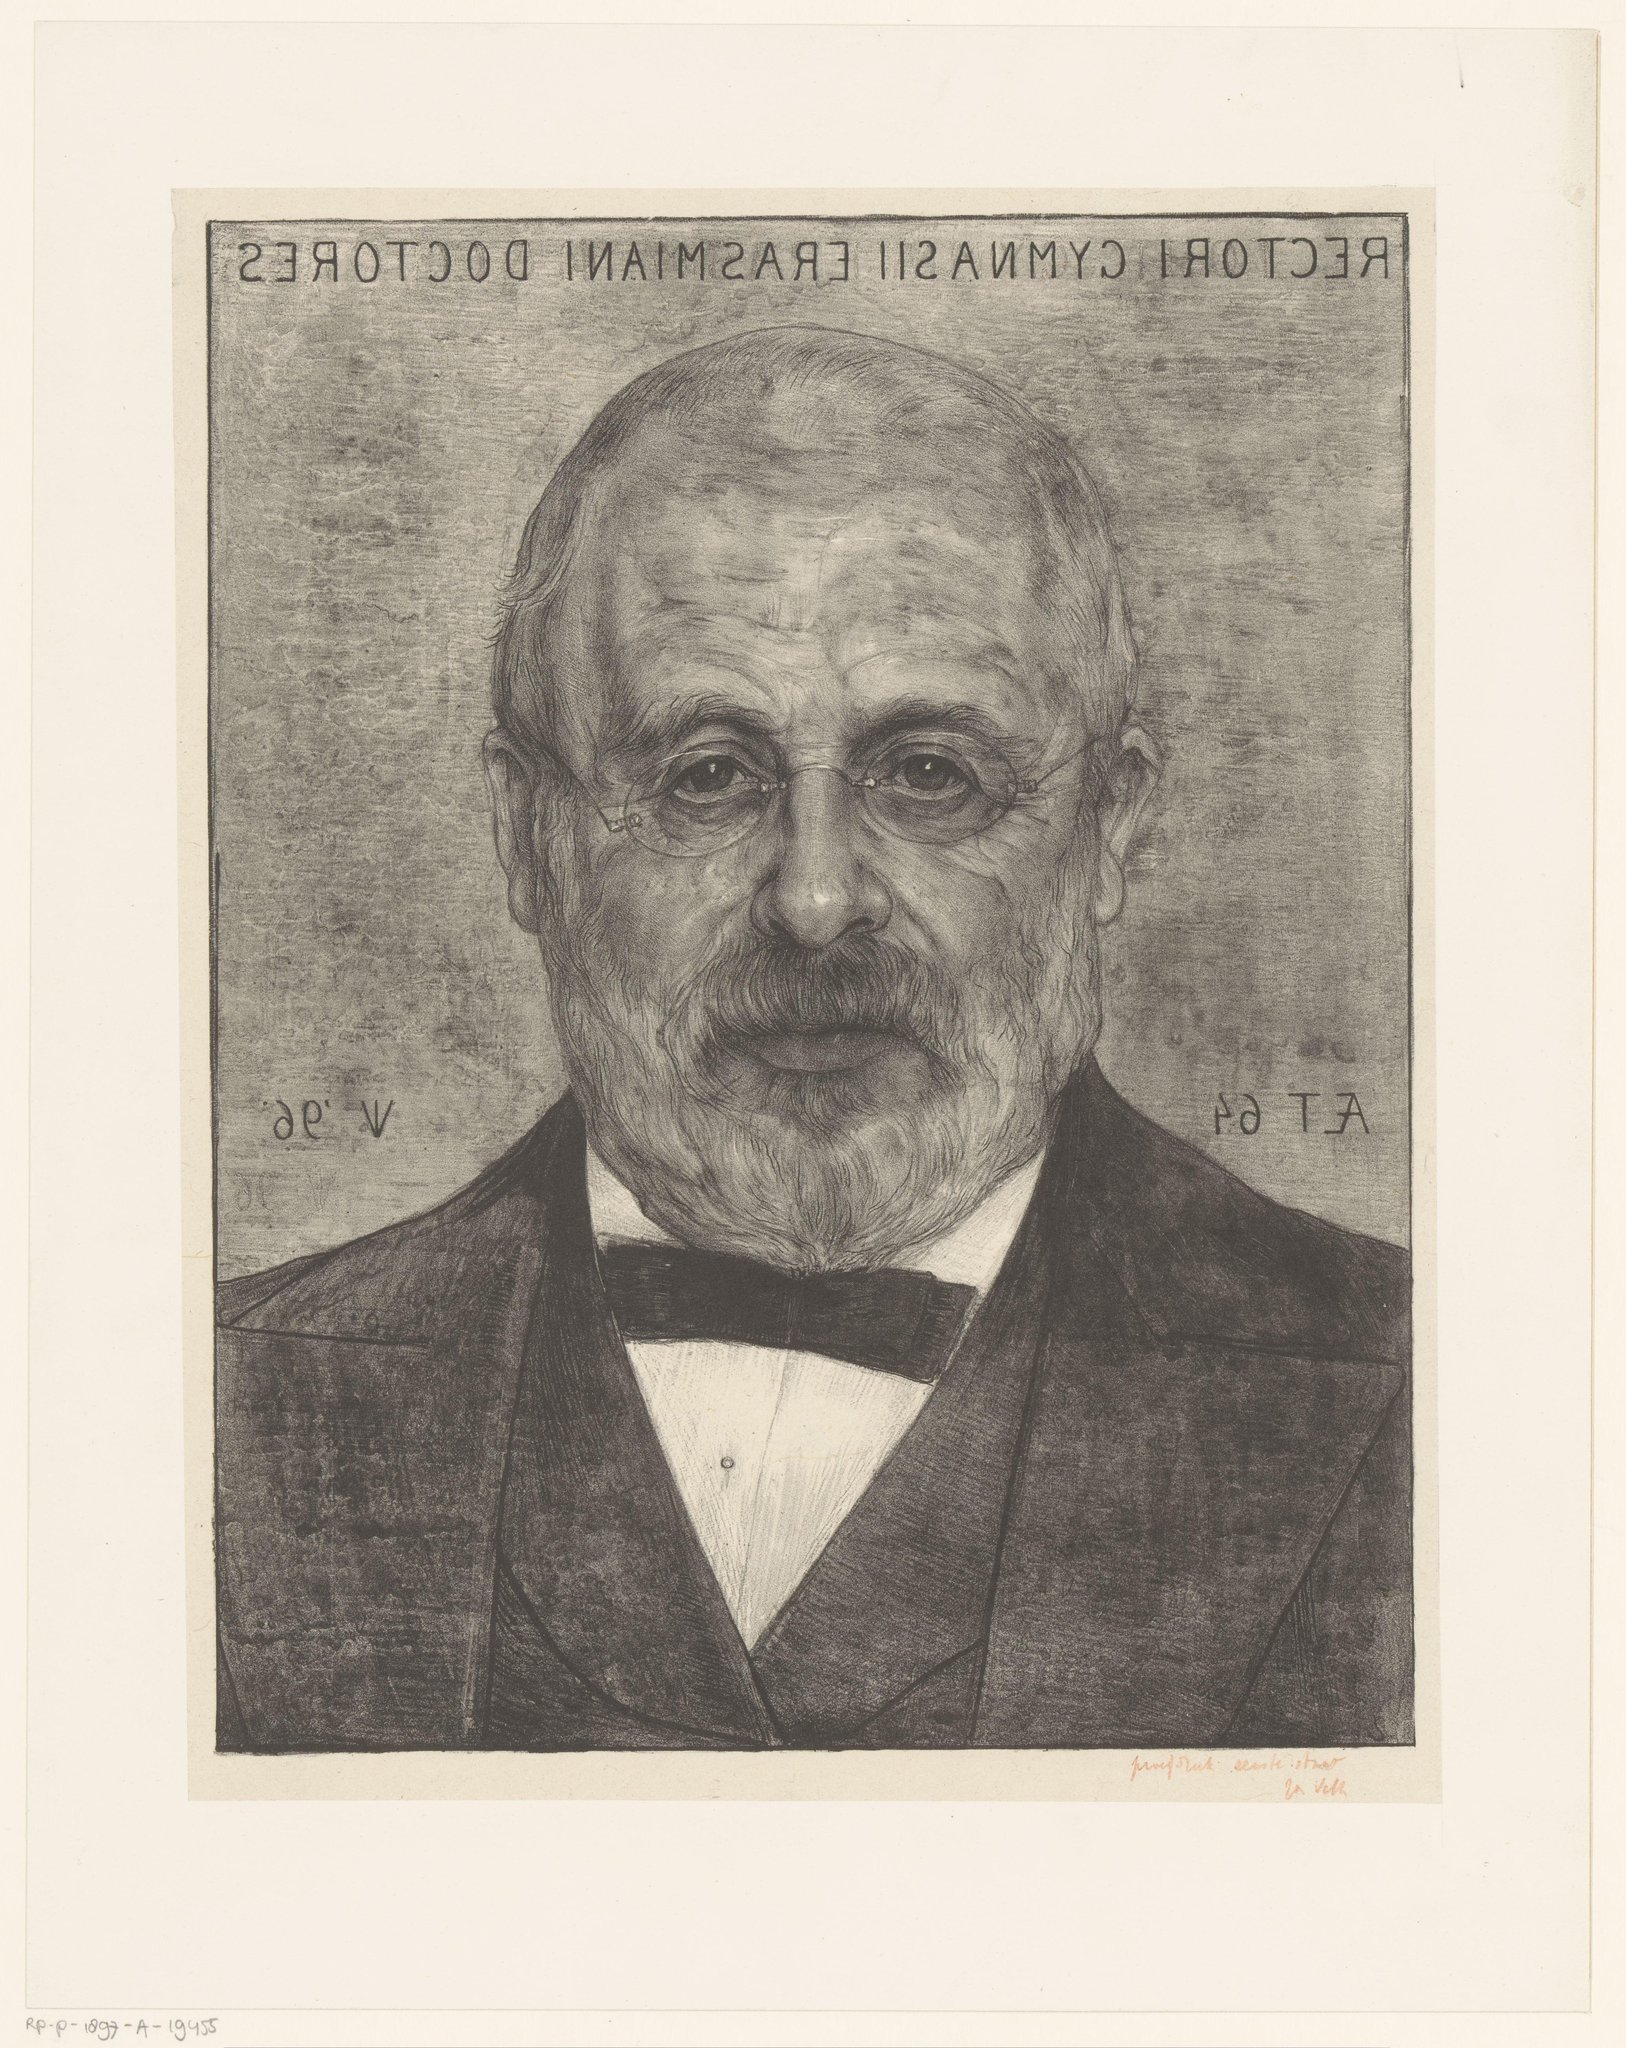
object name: print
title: Portret van Johannes Benedictus Kan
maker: jan veth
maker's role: designer, draughtsman, painter, print maker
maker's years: 1864-1925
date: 1896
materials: paper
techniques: lithograph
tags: historical persons (+ (full) bust portrait)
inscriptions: inscription: ‘proefdruk eerste staat / Jan Veth’, collector's mark: Lugt 2228